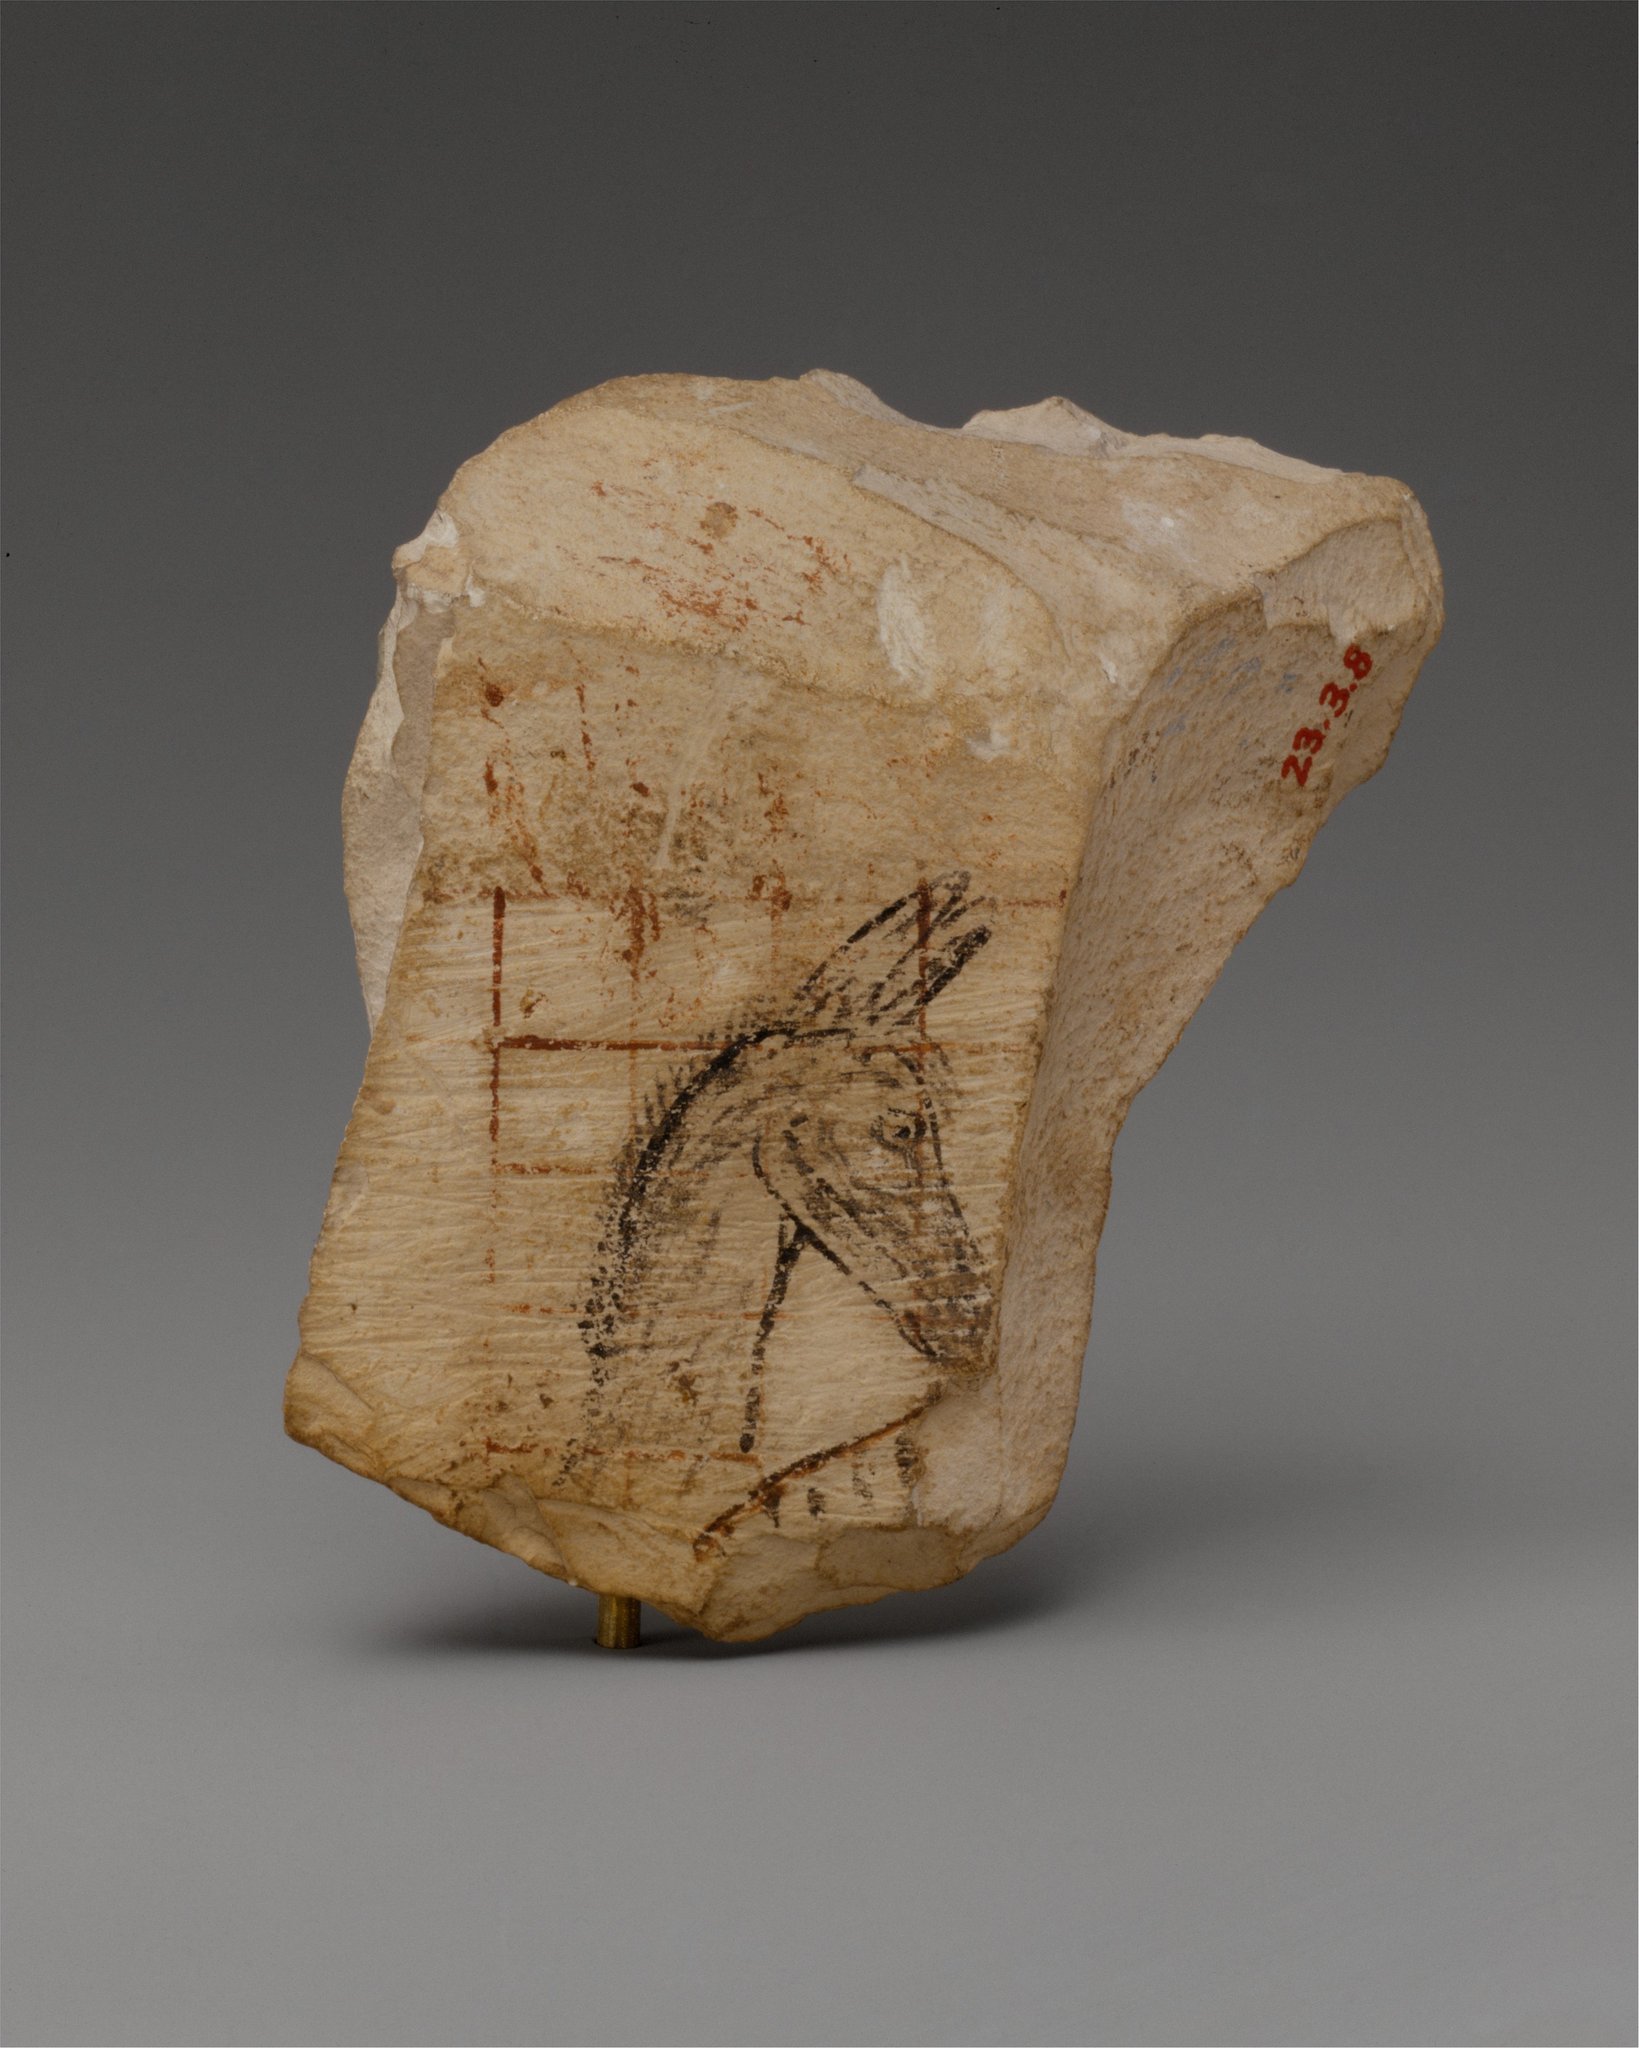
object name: ostracon, figured, donkey, grid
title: Ostracon with a donkey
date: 1479-1458 BCE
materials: ink, limestone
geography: egypt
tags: donkeys